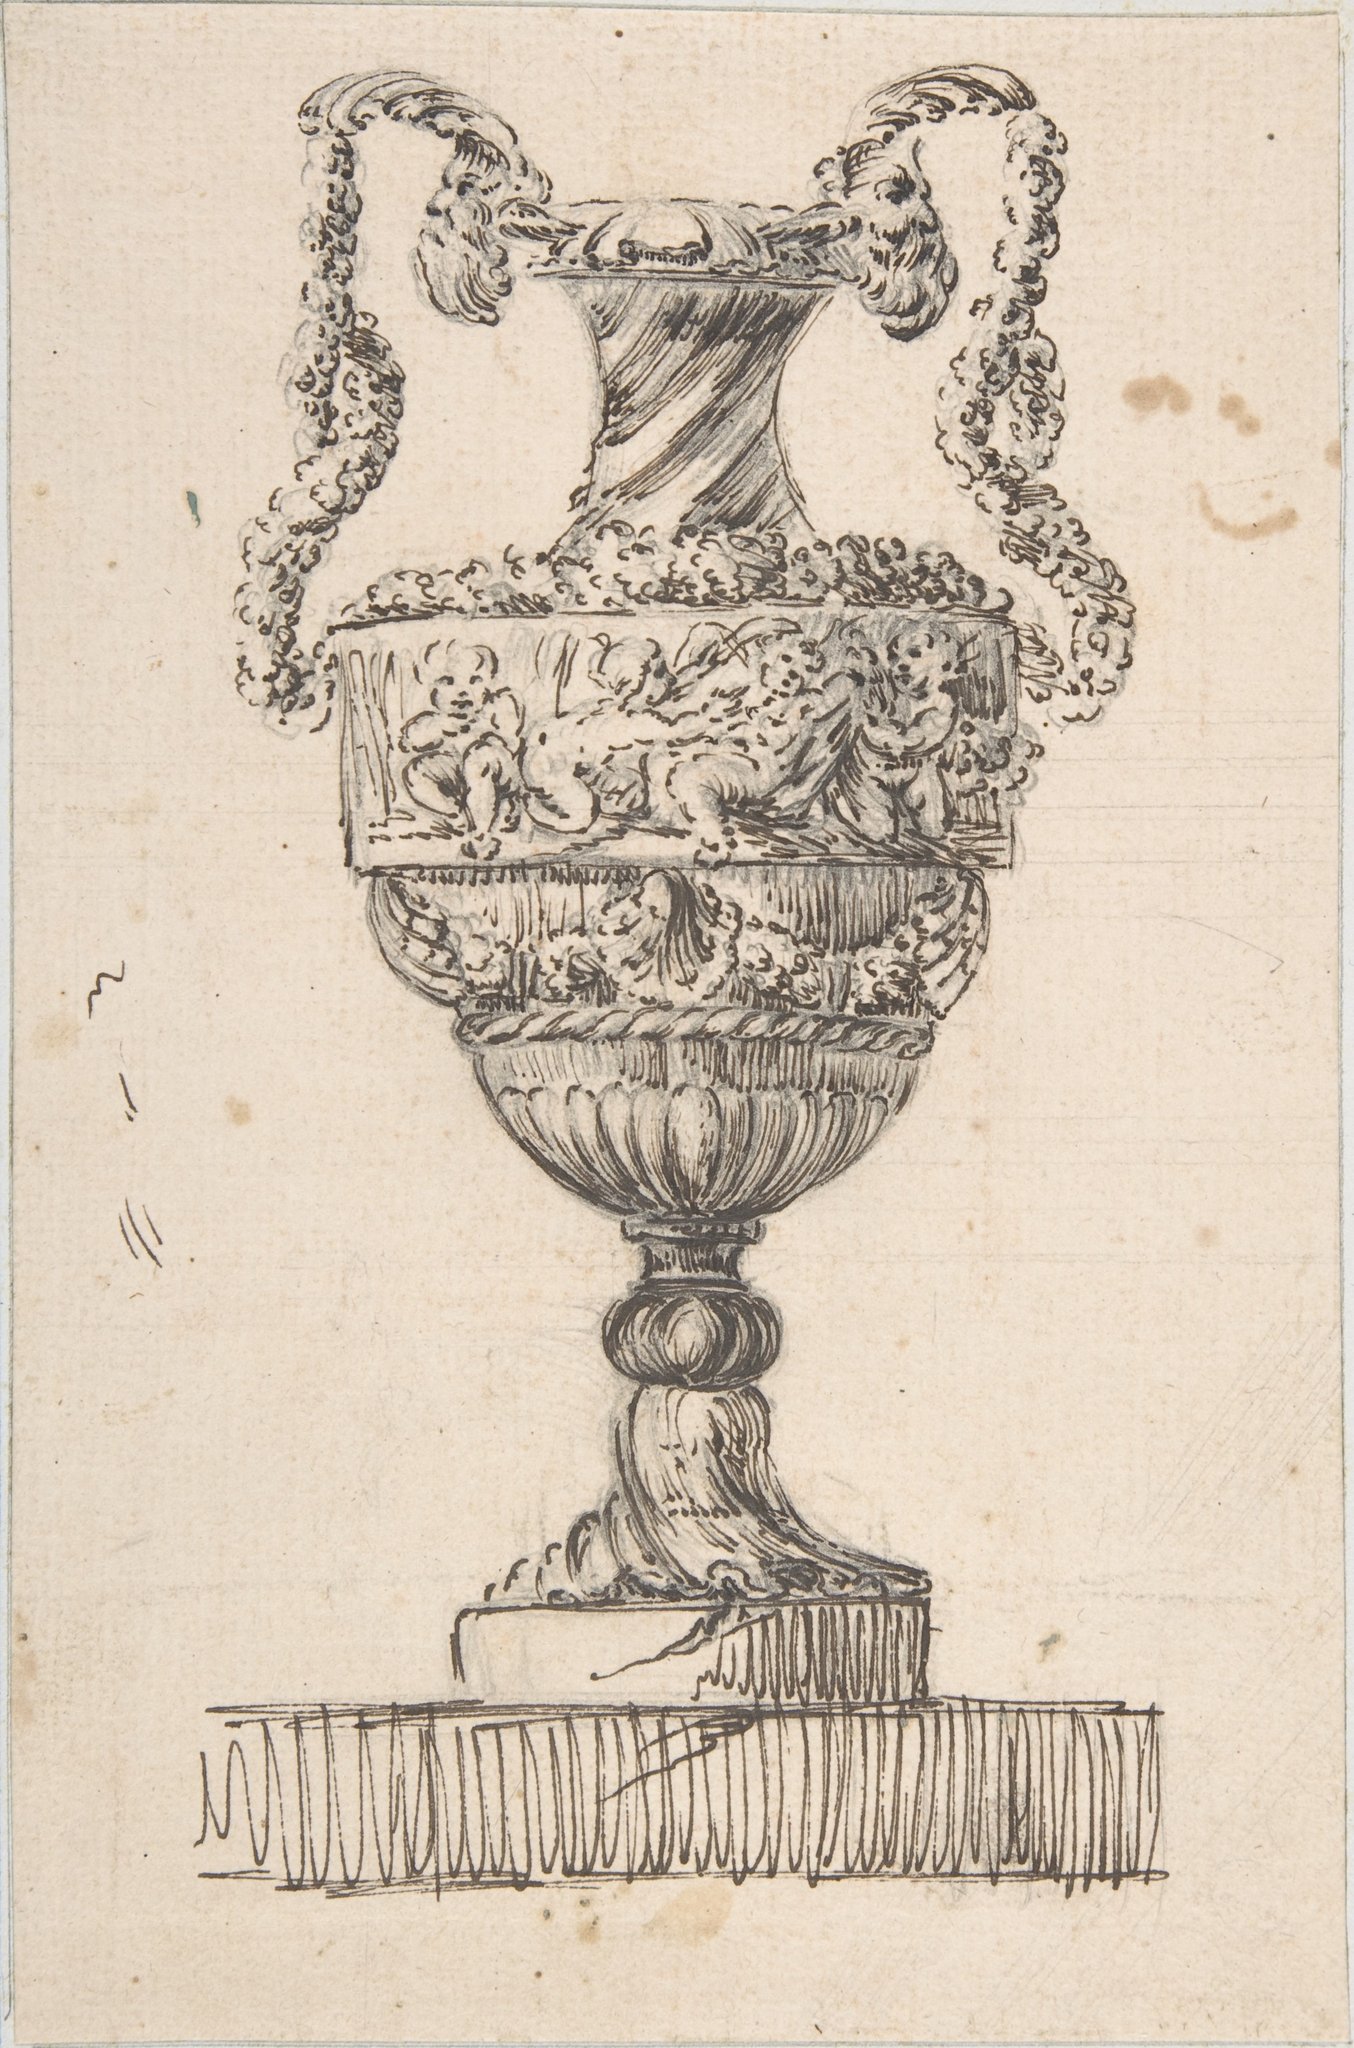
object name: drawing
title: Design for a Vase (recto); Sketch of Small Vase (verso)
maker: jacques françois joseph saly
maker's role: artist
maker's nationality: french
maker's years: 1717-1776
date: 1752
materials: graphite, ink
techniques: pen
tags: vases